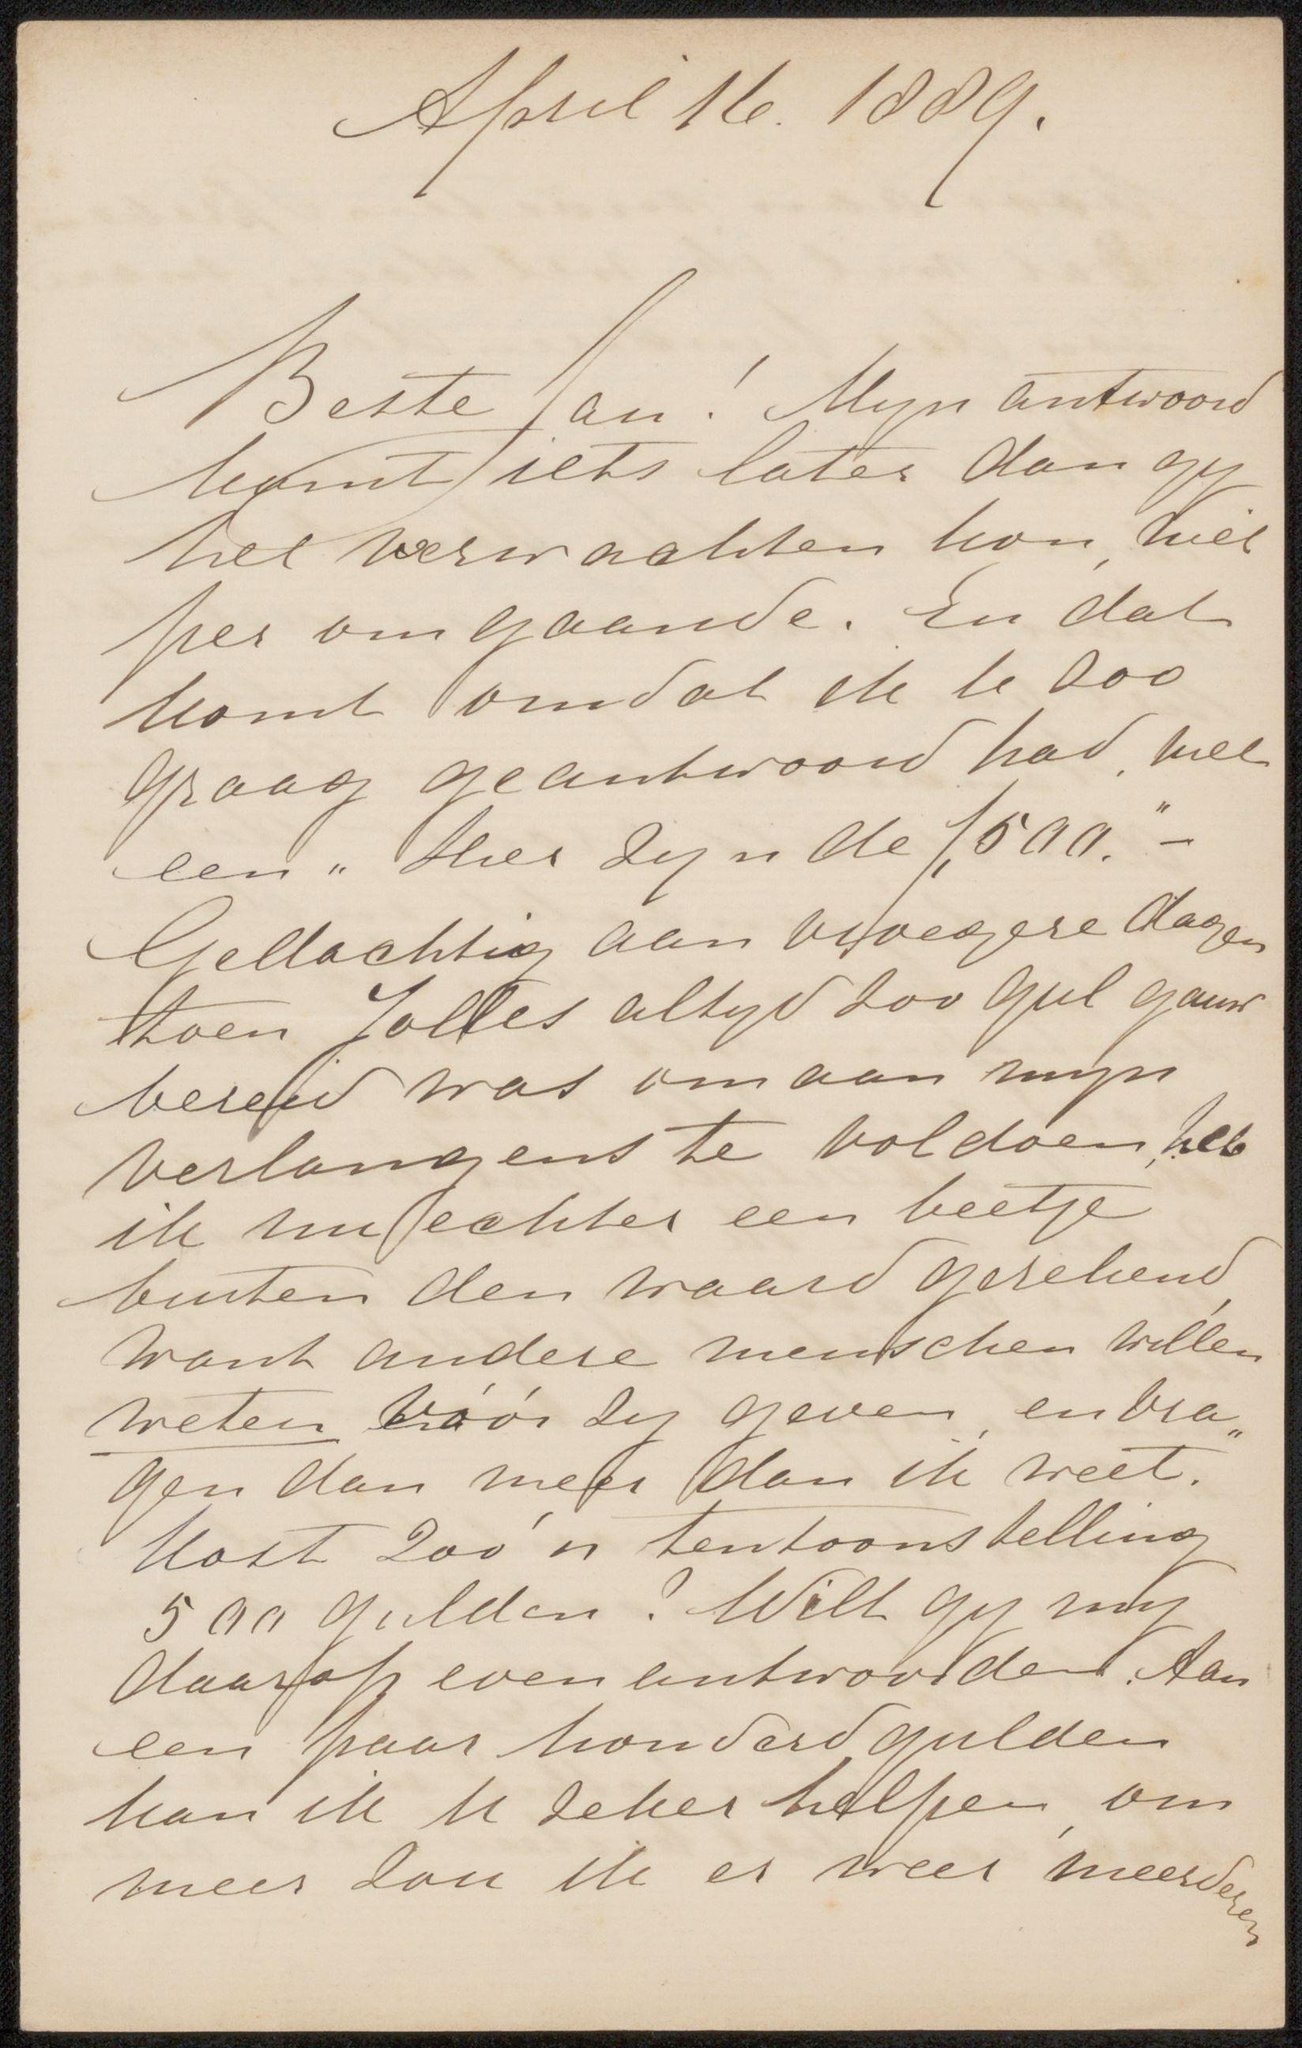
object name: letter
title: Brief aan Jan Veth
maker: jacoba cornelia jolles-singels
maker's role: schrijver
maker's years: 1847-1901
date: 1889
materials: ink, paper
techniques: pen, writing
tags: dordrecht, designer, jan veth, den bosch, amsterdam, painter, print maker, draughtsman, antoon derkinderen, exhibition ~ art, money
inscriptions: collector's mark: ‘RPK’